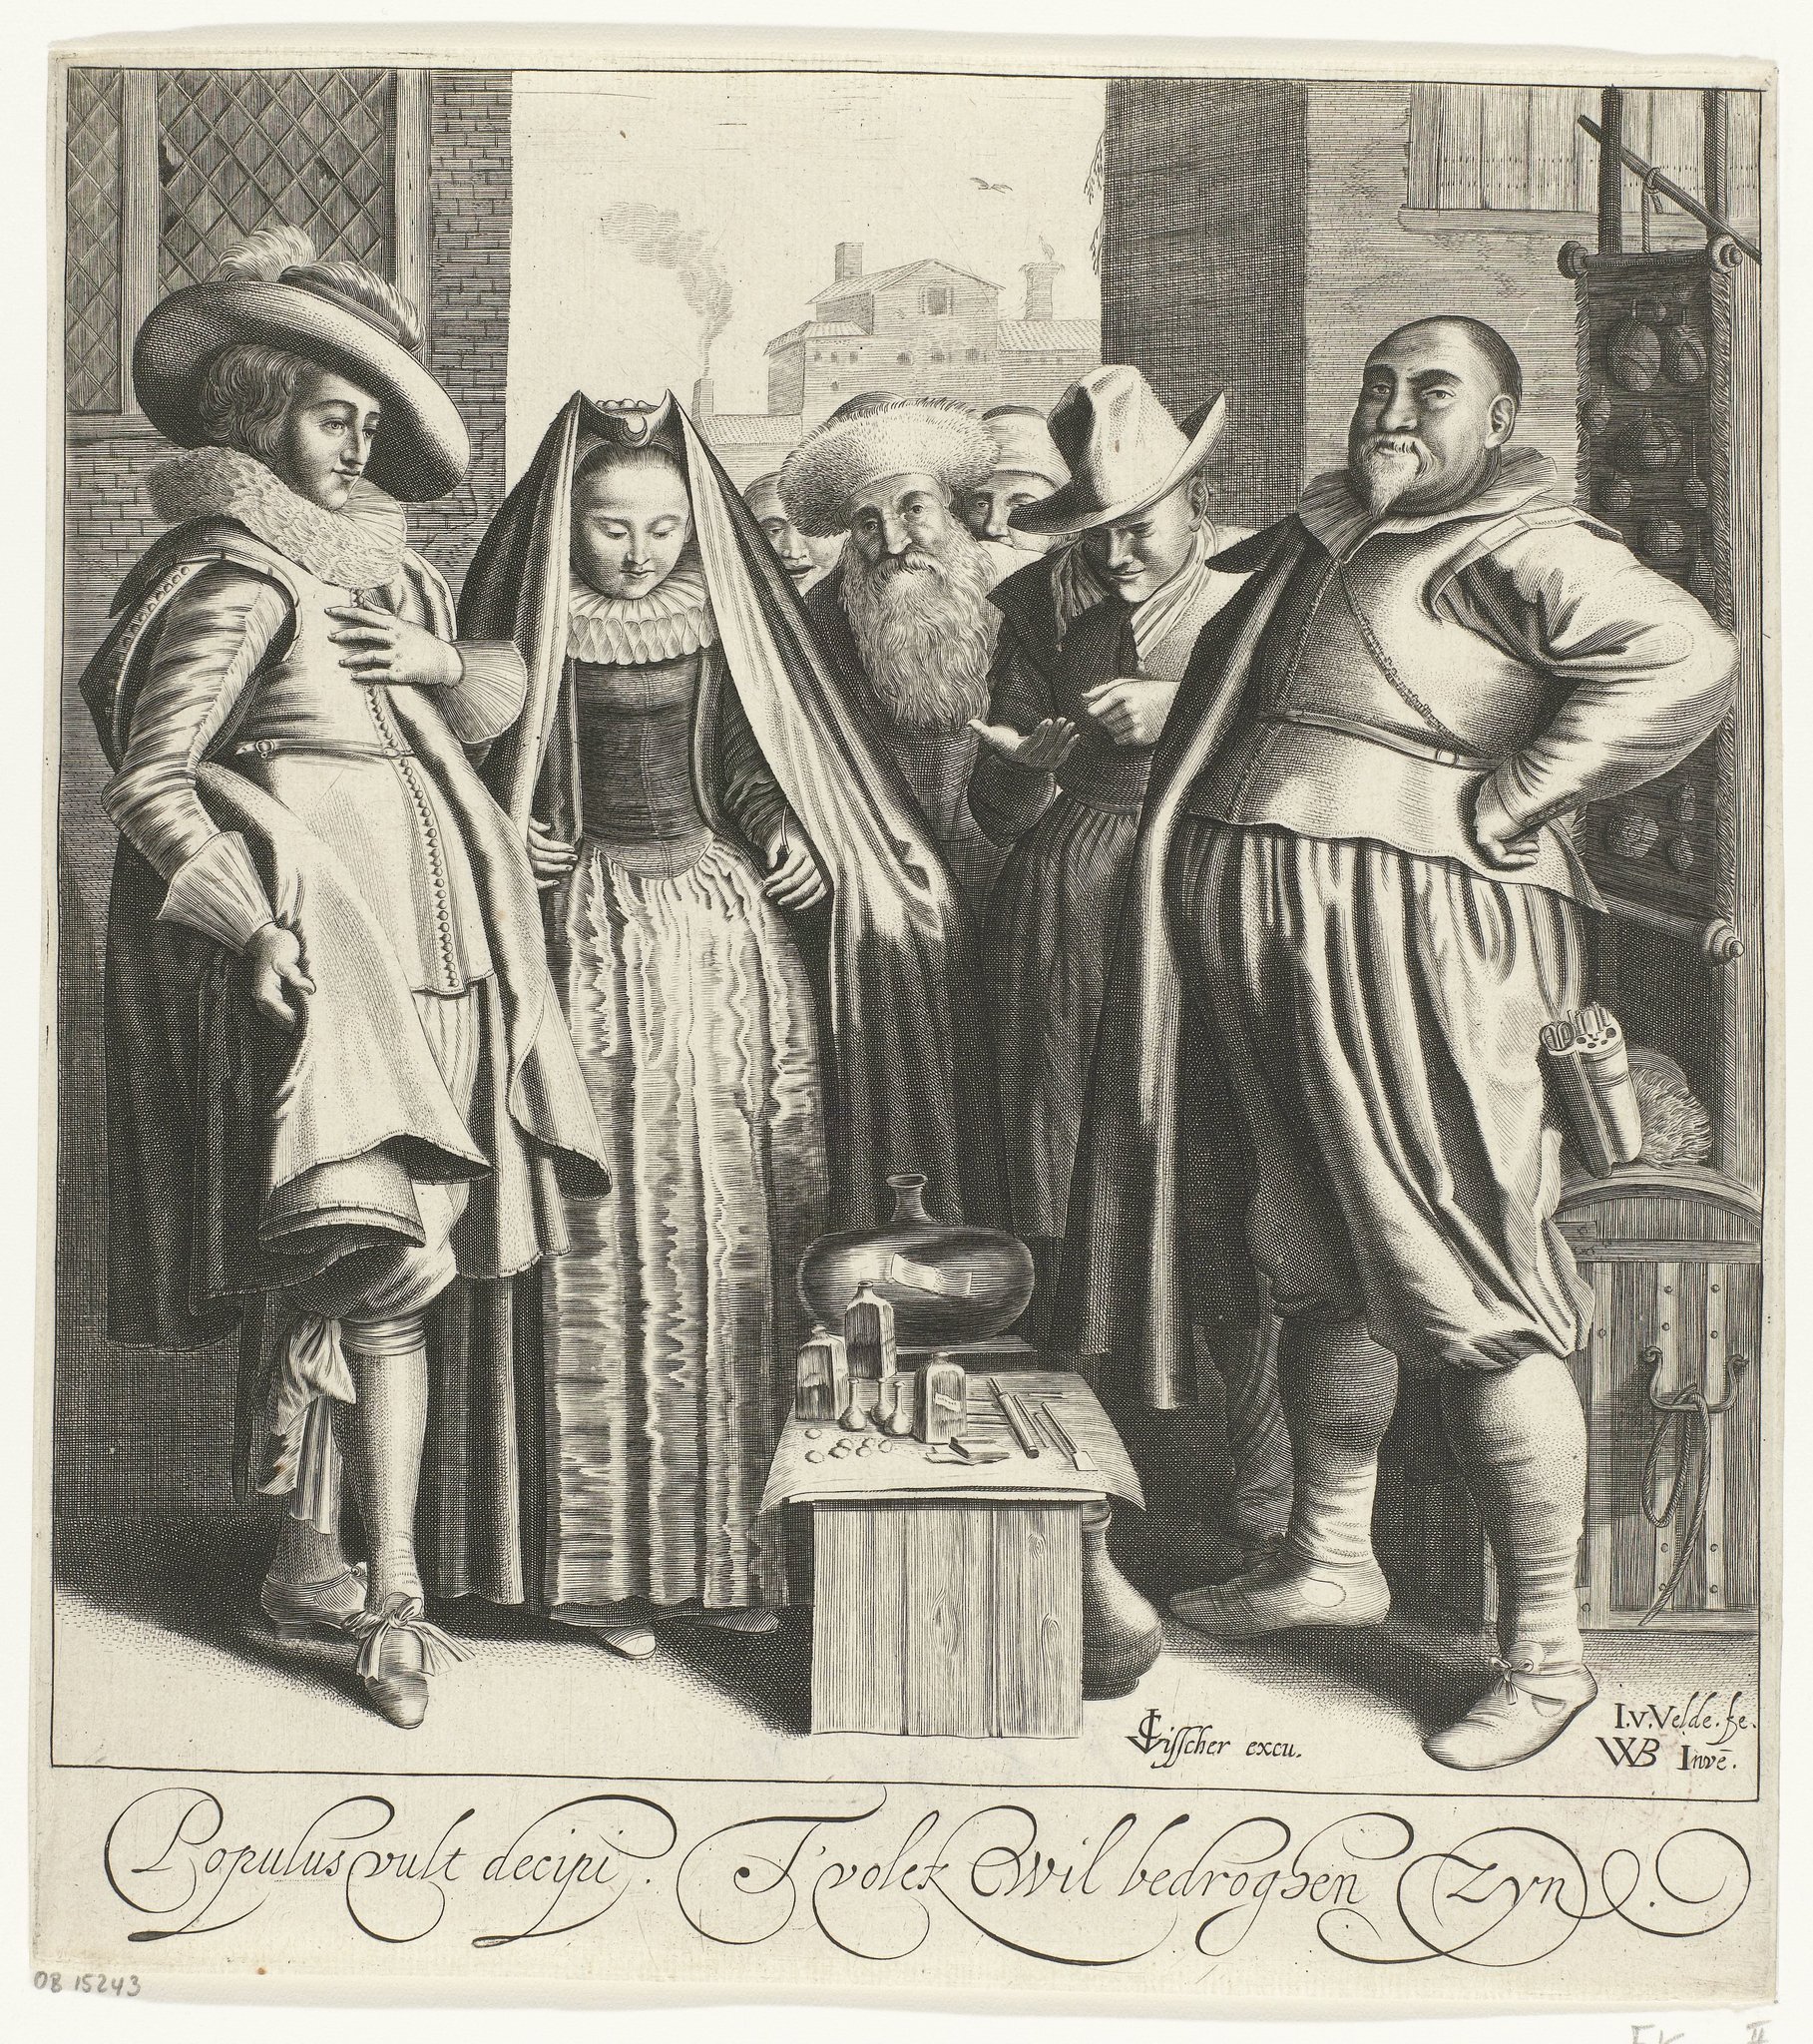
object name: print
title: T'volck wil bedrogen zyn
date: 1603-1652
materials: paper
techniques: engraving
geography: amsterdam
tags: head-gear: hat (+ fur used for clothes), head-gear (with name), neck-gear ~ clothing (with name) (+ men's clothes), belt, girdle, waistband (+ men's clothes), cape (+ men's clothes), cape (huik) (+ women's clothes), quack, charlatan, mountebank, 'saltimbanco', clothes, costume (+ women's clothes), skirt (+ women's clothes), shoes, sandals (+ men's clothes), proverbs, sayings, etc., clothes, costume (+ men's clothes), clothing for the upper part of the body (with name) (+ women's clothes)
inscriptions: title: ‘T'volck wil bedrogen zyn’, collector's mark: Lugt 240, signature: ‘Populus vult decipi’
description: Een grote dikke man, de kwakzalver, staat voor een groep omstanders. Op een laag tafeltje staan zijn attributen: flessen, pincetten, mesjes en enkele 'stenen'. Een elegant paar staat voor hem. De heer naast hem zoekt in zijn hand geld om de kwakzalver te betalen. Naast hem een oude man met lange baard en bontmuts op. Achter de kwakzalver of 'keisnijder' hangt een doek aan twee stokken waarop stenen tentoongesteld zijn, als de zichtbare bewijzen van goed geslaagde 'kei-operaties'.